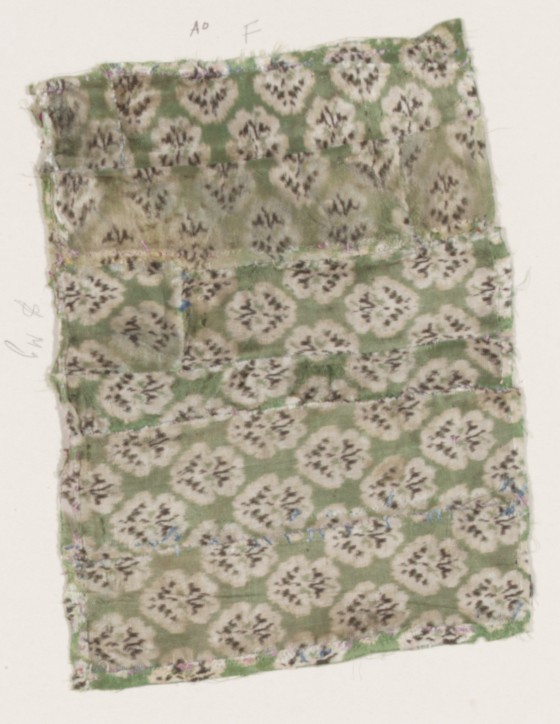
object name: fragment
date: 1701-1800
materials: silk